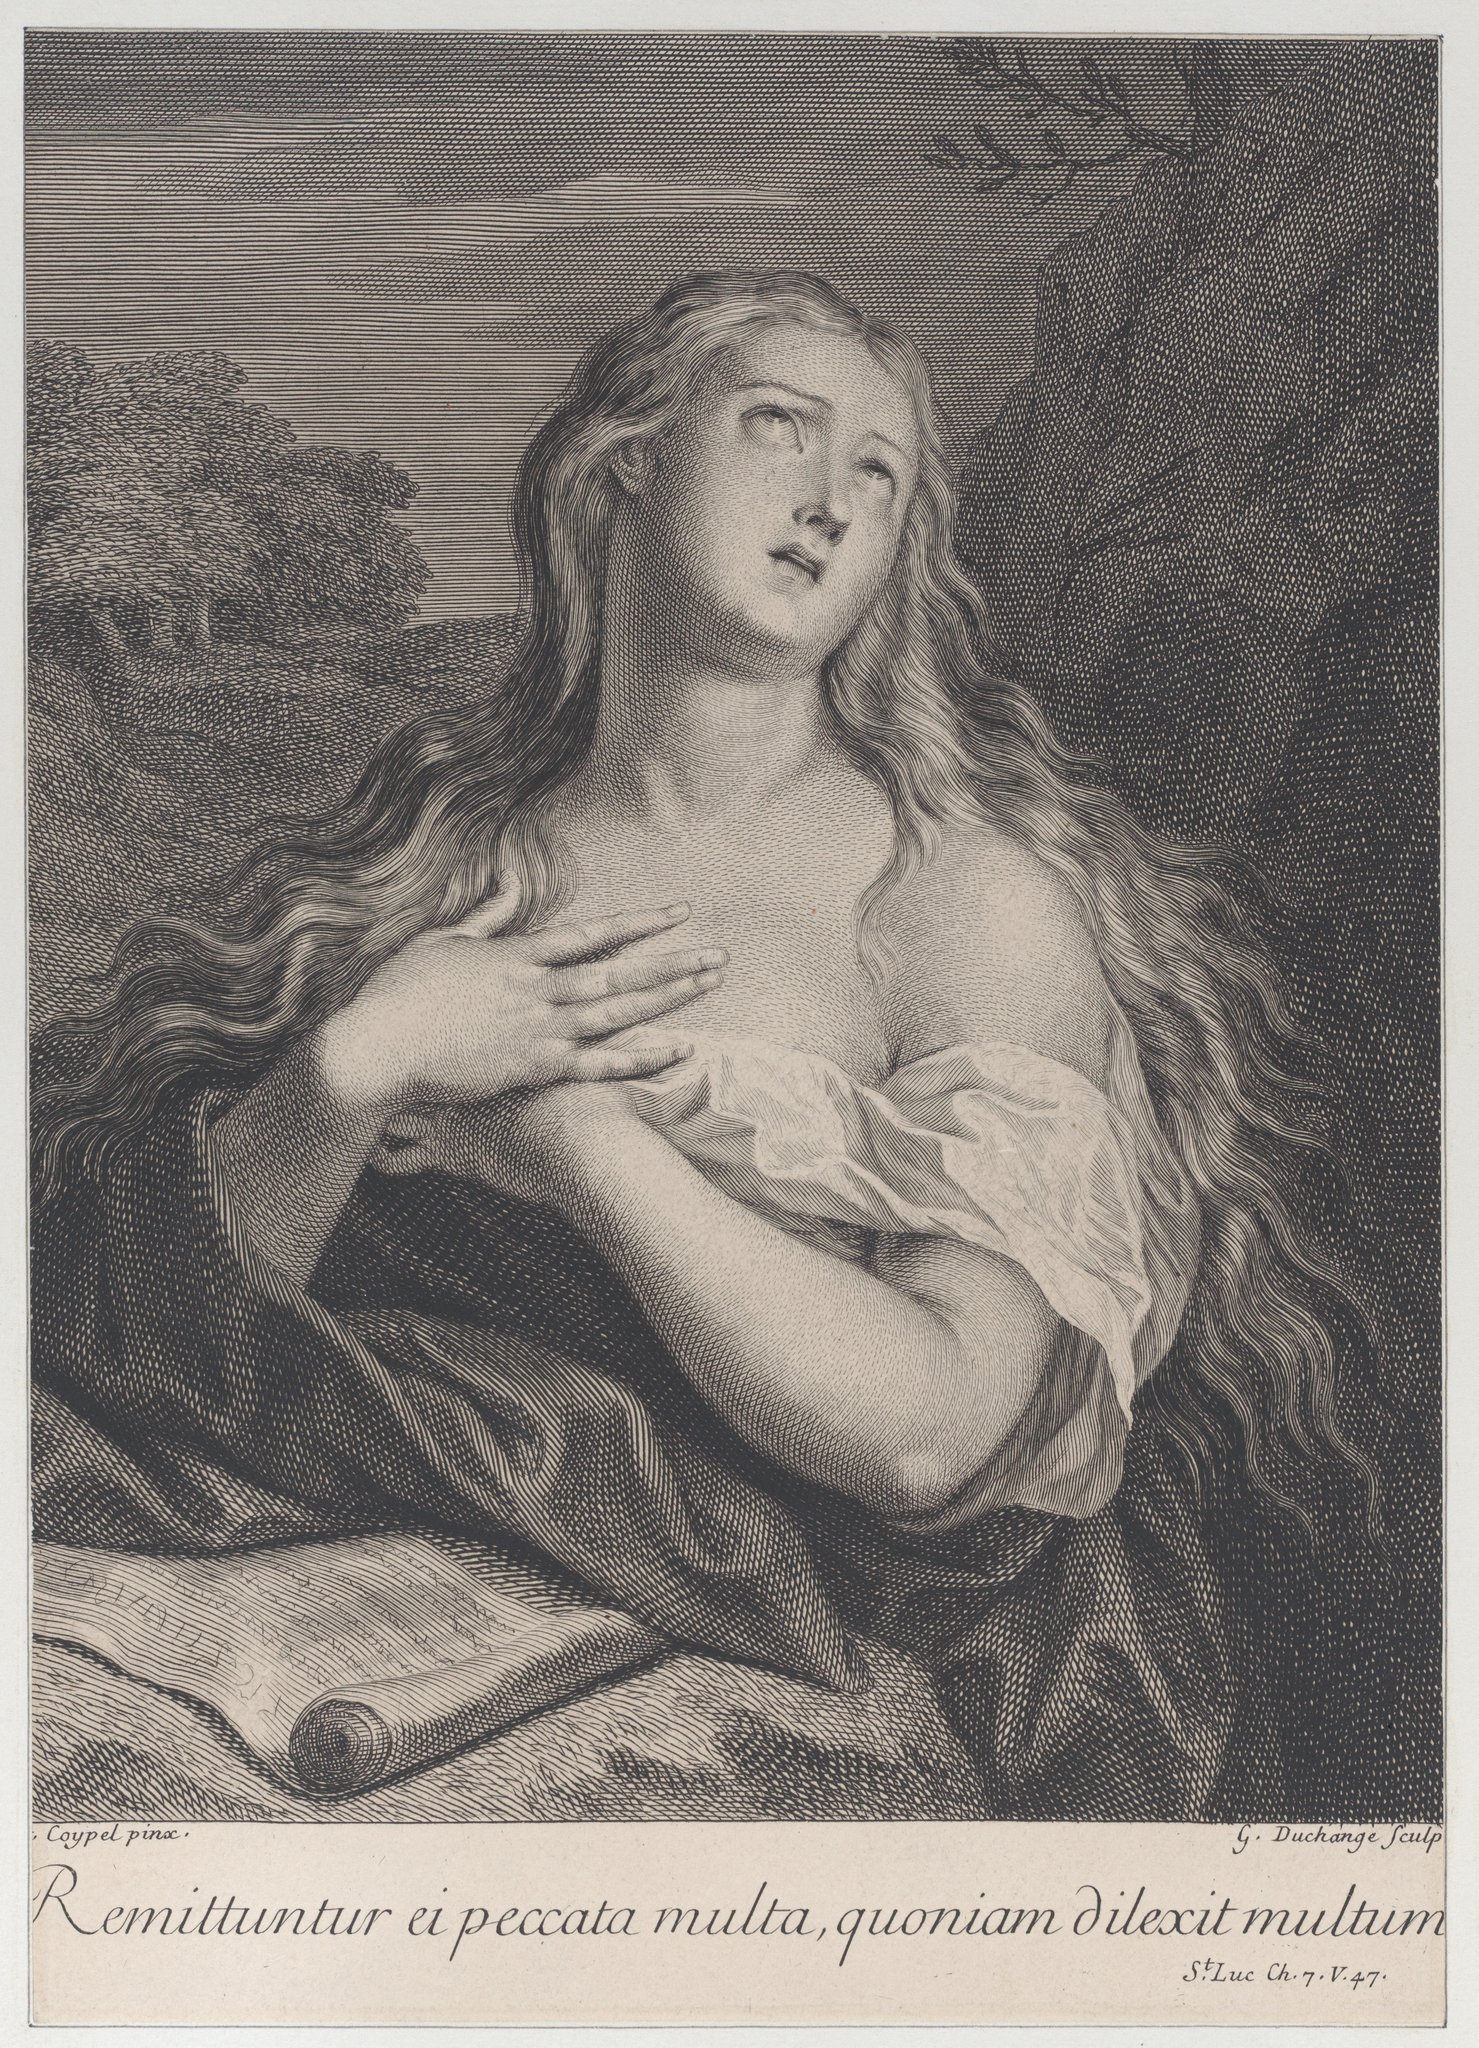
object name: print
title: The penitent Mary Magdalene in the wilderness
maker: gaspard duchange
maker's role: artist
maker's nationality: french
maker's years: 1662-1757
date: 1682-1757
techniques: engraving